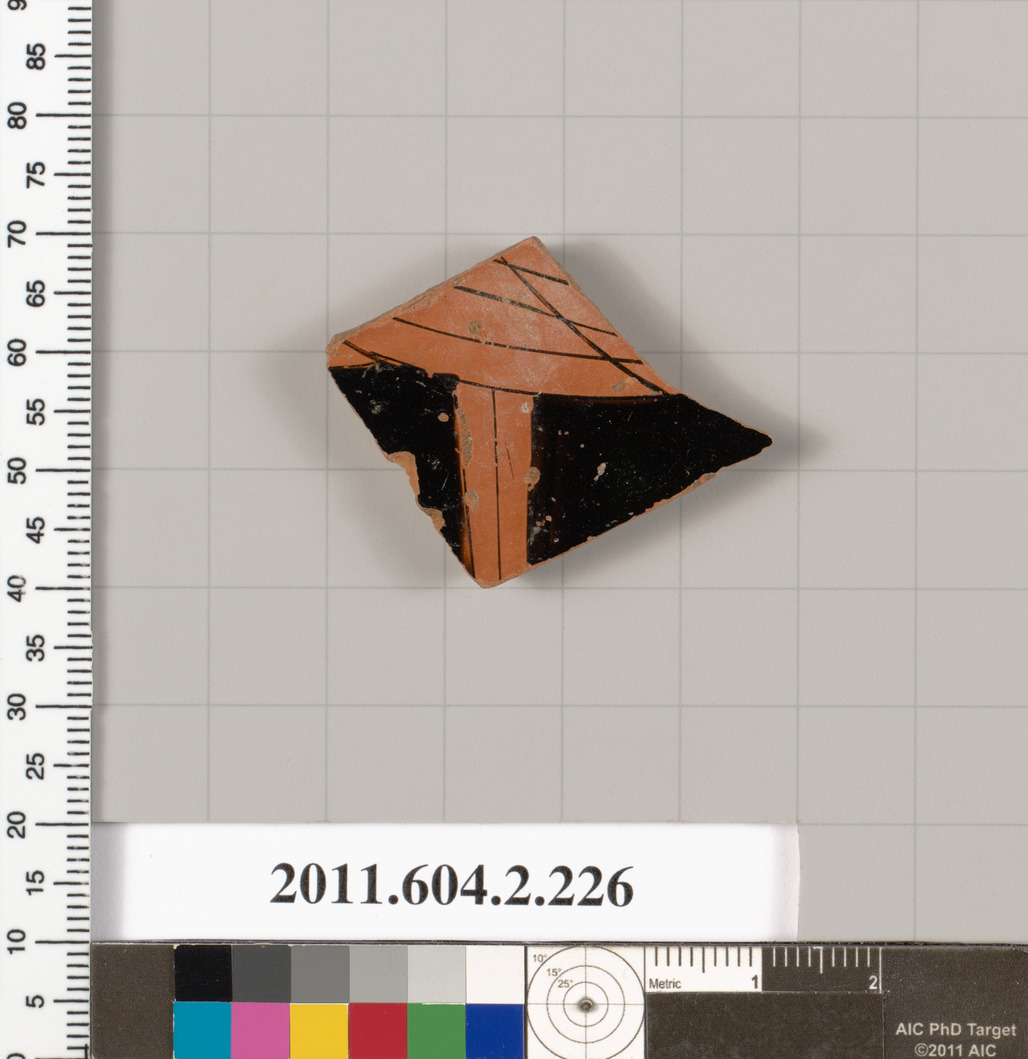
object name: stamnos fragment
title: Terracotta fragment of a stamnos (jar)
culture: greek, attic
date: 475-451 BCE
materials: terracotta